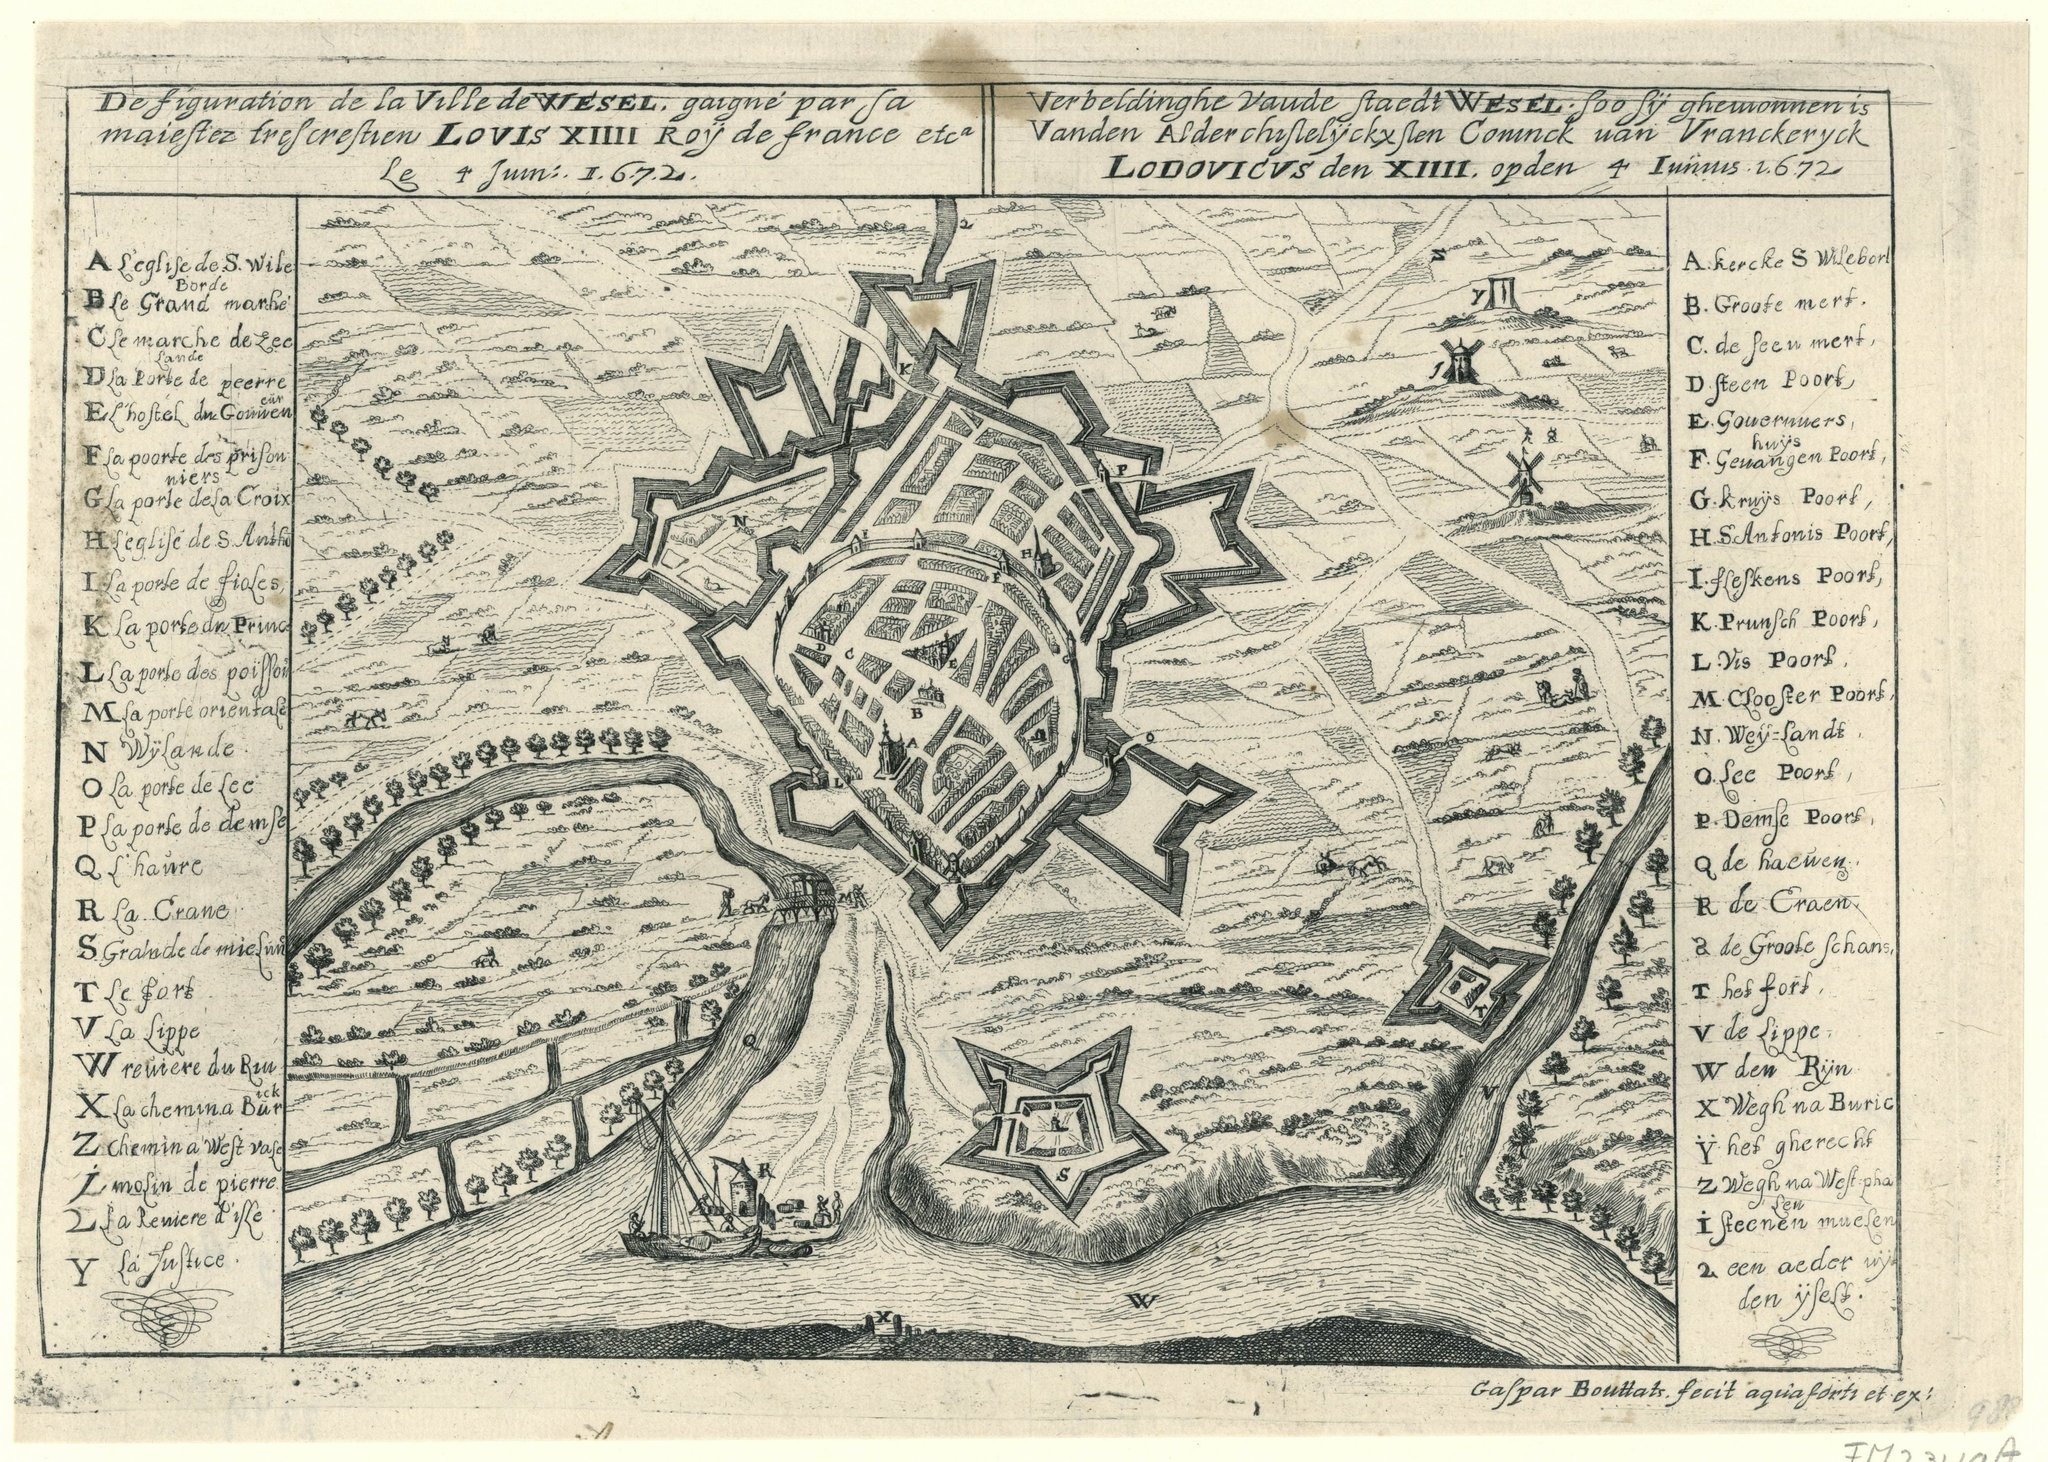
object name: print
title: Plattegrond van Wesel, veroverd door de Fransen in 1672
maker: gaspar bouttats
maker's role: print maker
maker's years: 1640-1695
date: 1672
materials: paper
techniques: etching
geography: antwerp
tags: maps of cities, rampjaar (disaster year)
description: Gezicht op de stad Wezel. Deze prent maakt deel uit van een groep van twaalf prenten, merendeels geëetst en uitgegeven door Gaspar Bouttats, met gezichten op vestingen en steden veroverd door de Fransen en Munstersen in 1672. Plattegronden met legenda's in Frans en Nederlands.